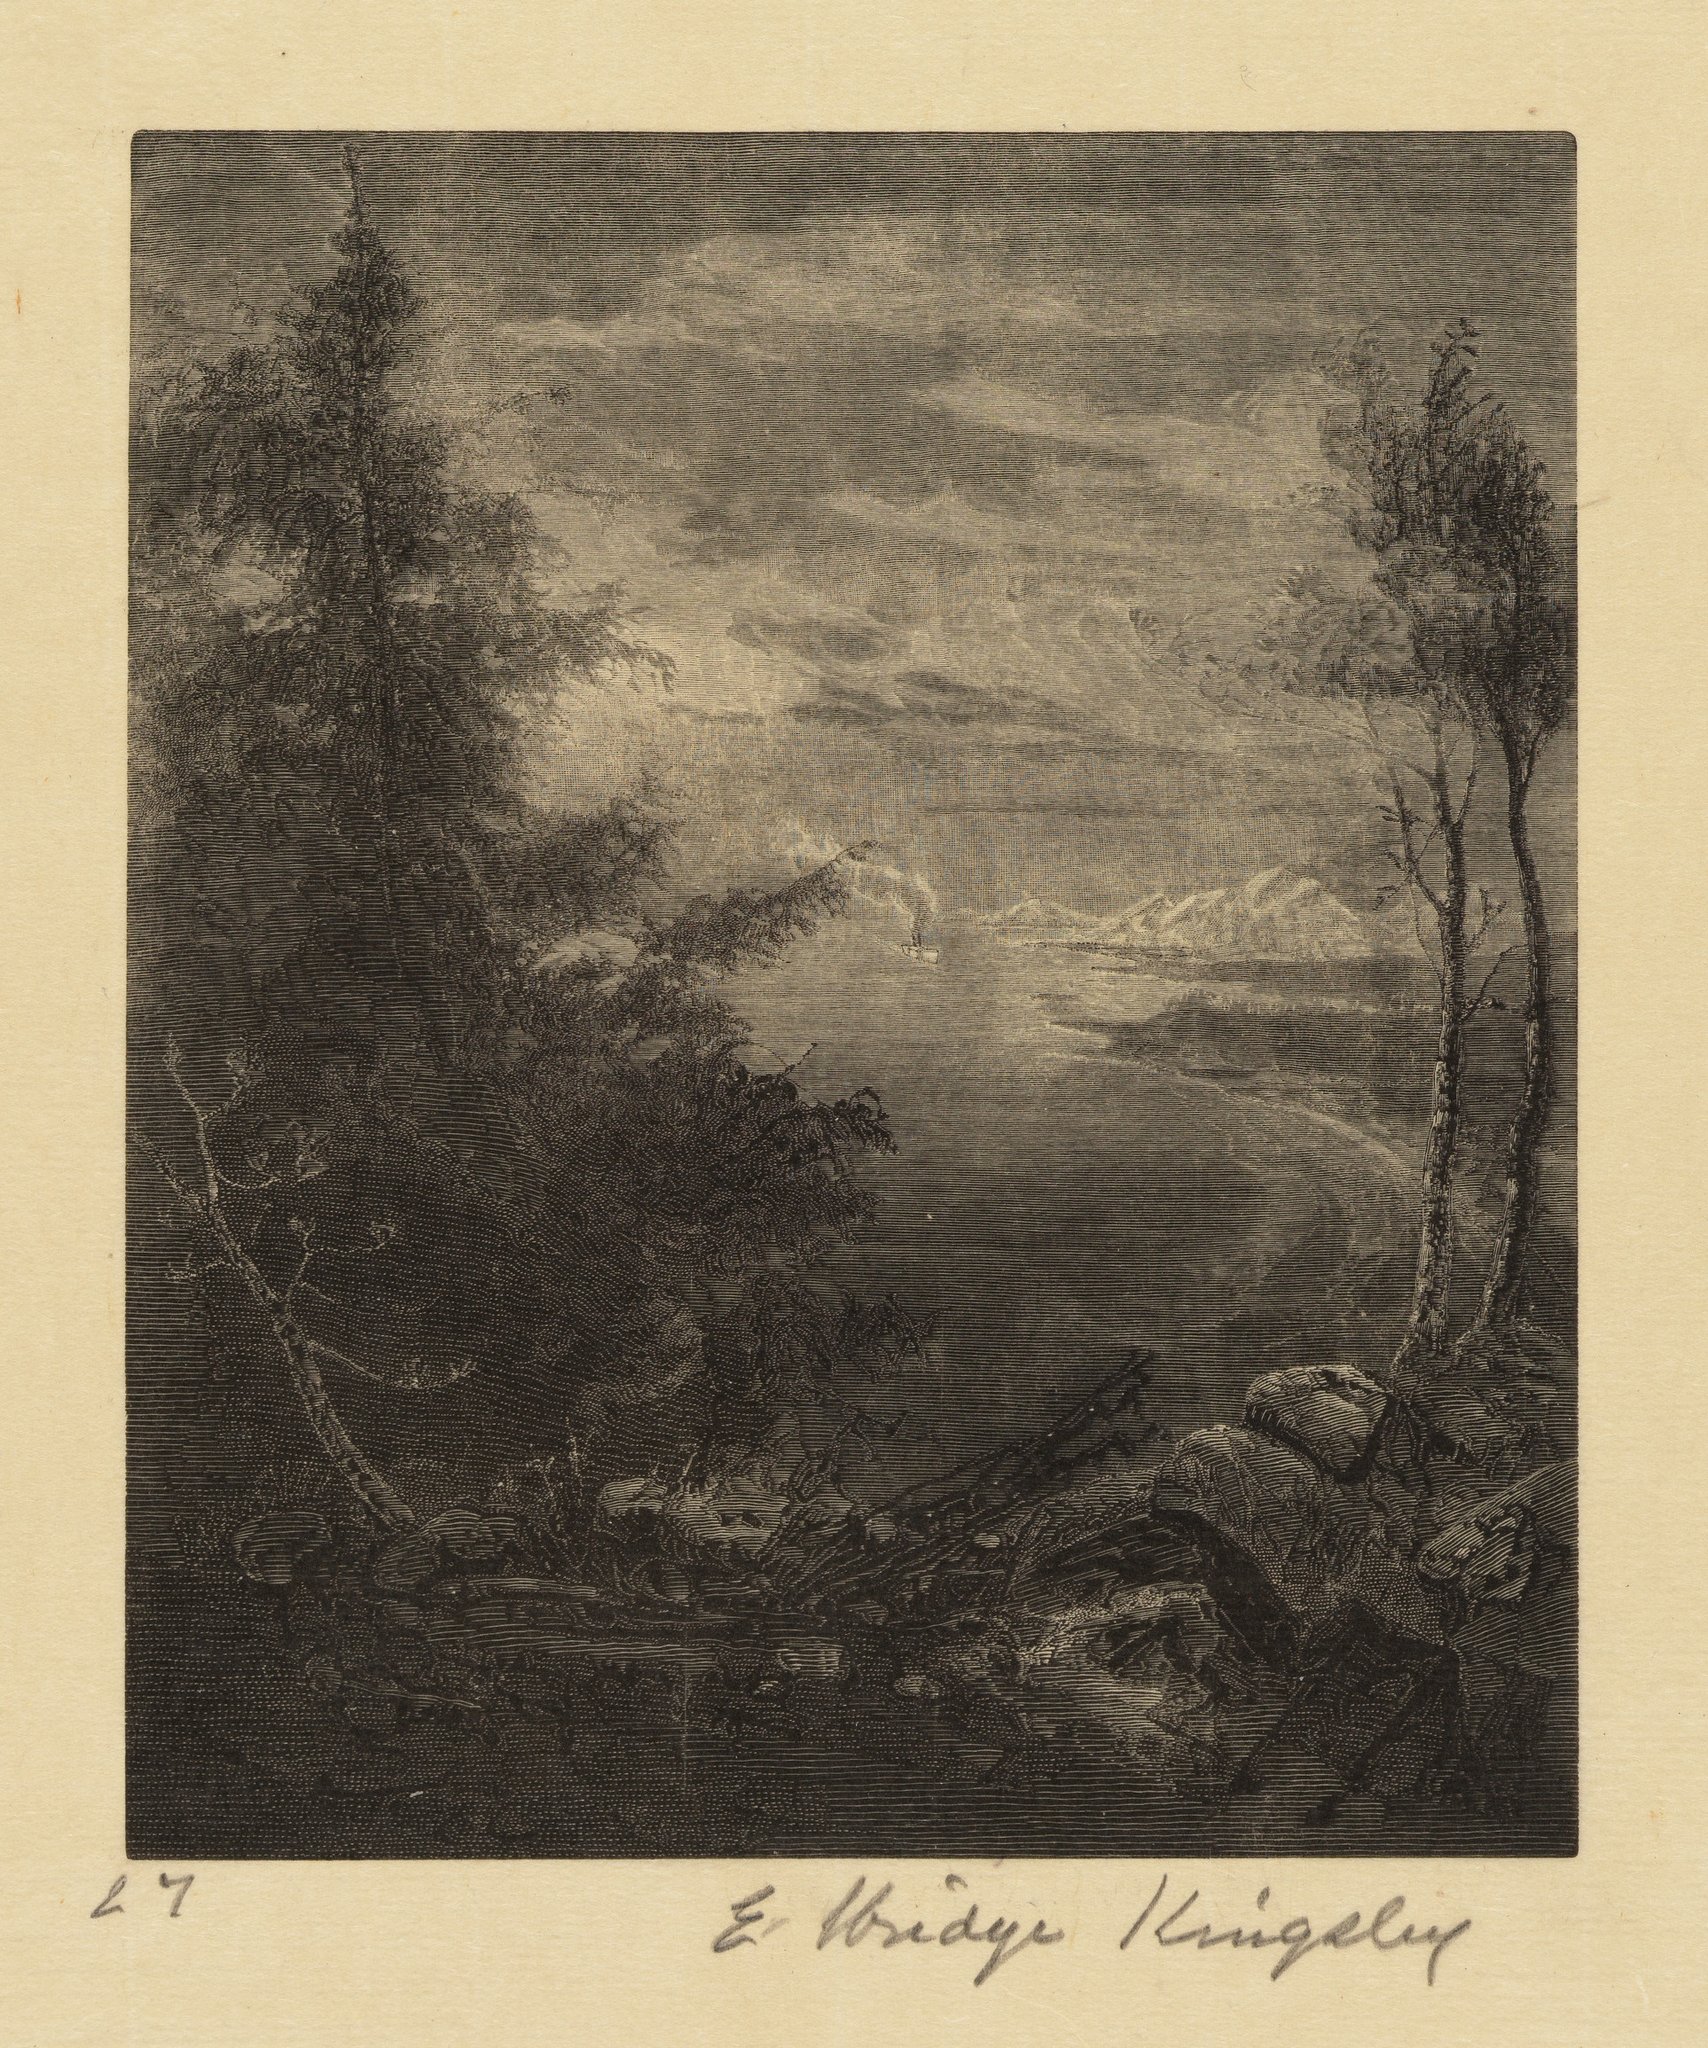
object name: print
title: The Lakeside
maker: elbridge kingsley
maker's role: artist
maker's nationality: american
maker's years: 1841-1918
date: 1860-1915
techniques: engraving